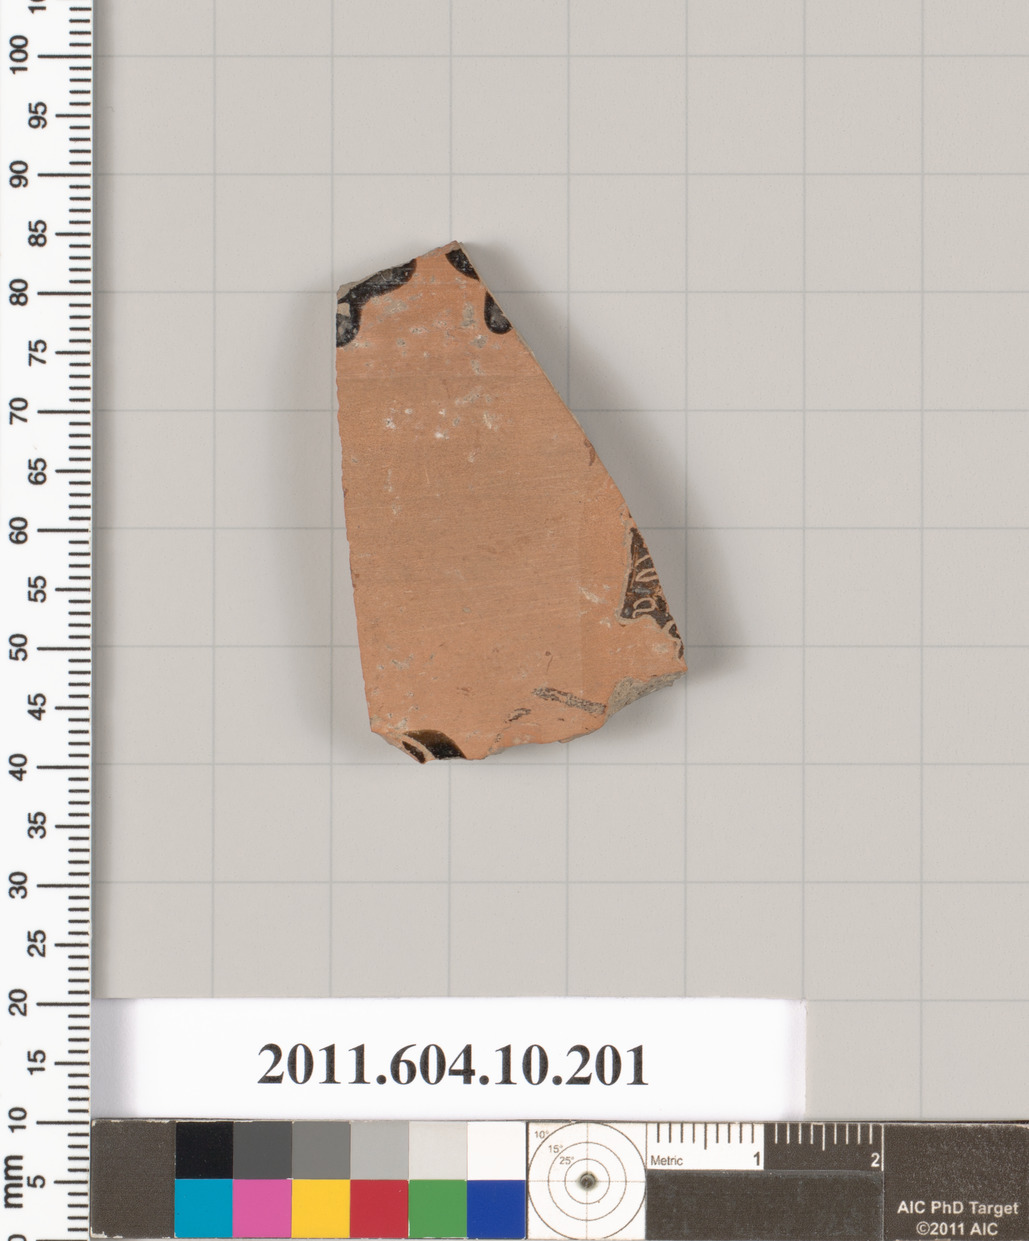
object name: undetermined closed shape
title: Terracotta fragment from a closed shape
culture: etruscan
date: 534-468 BCE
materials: terracotta